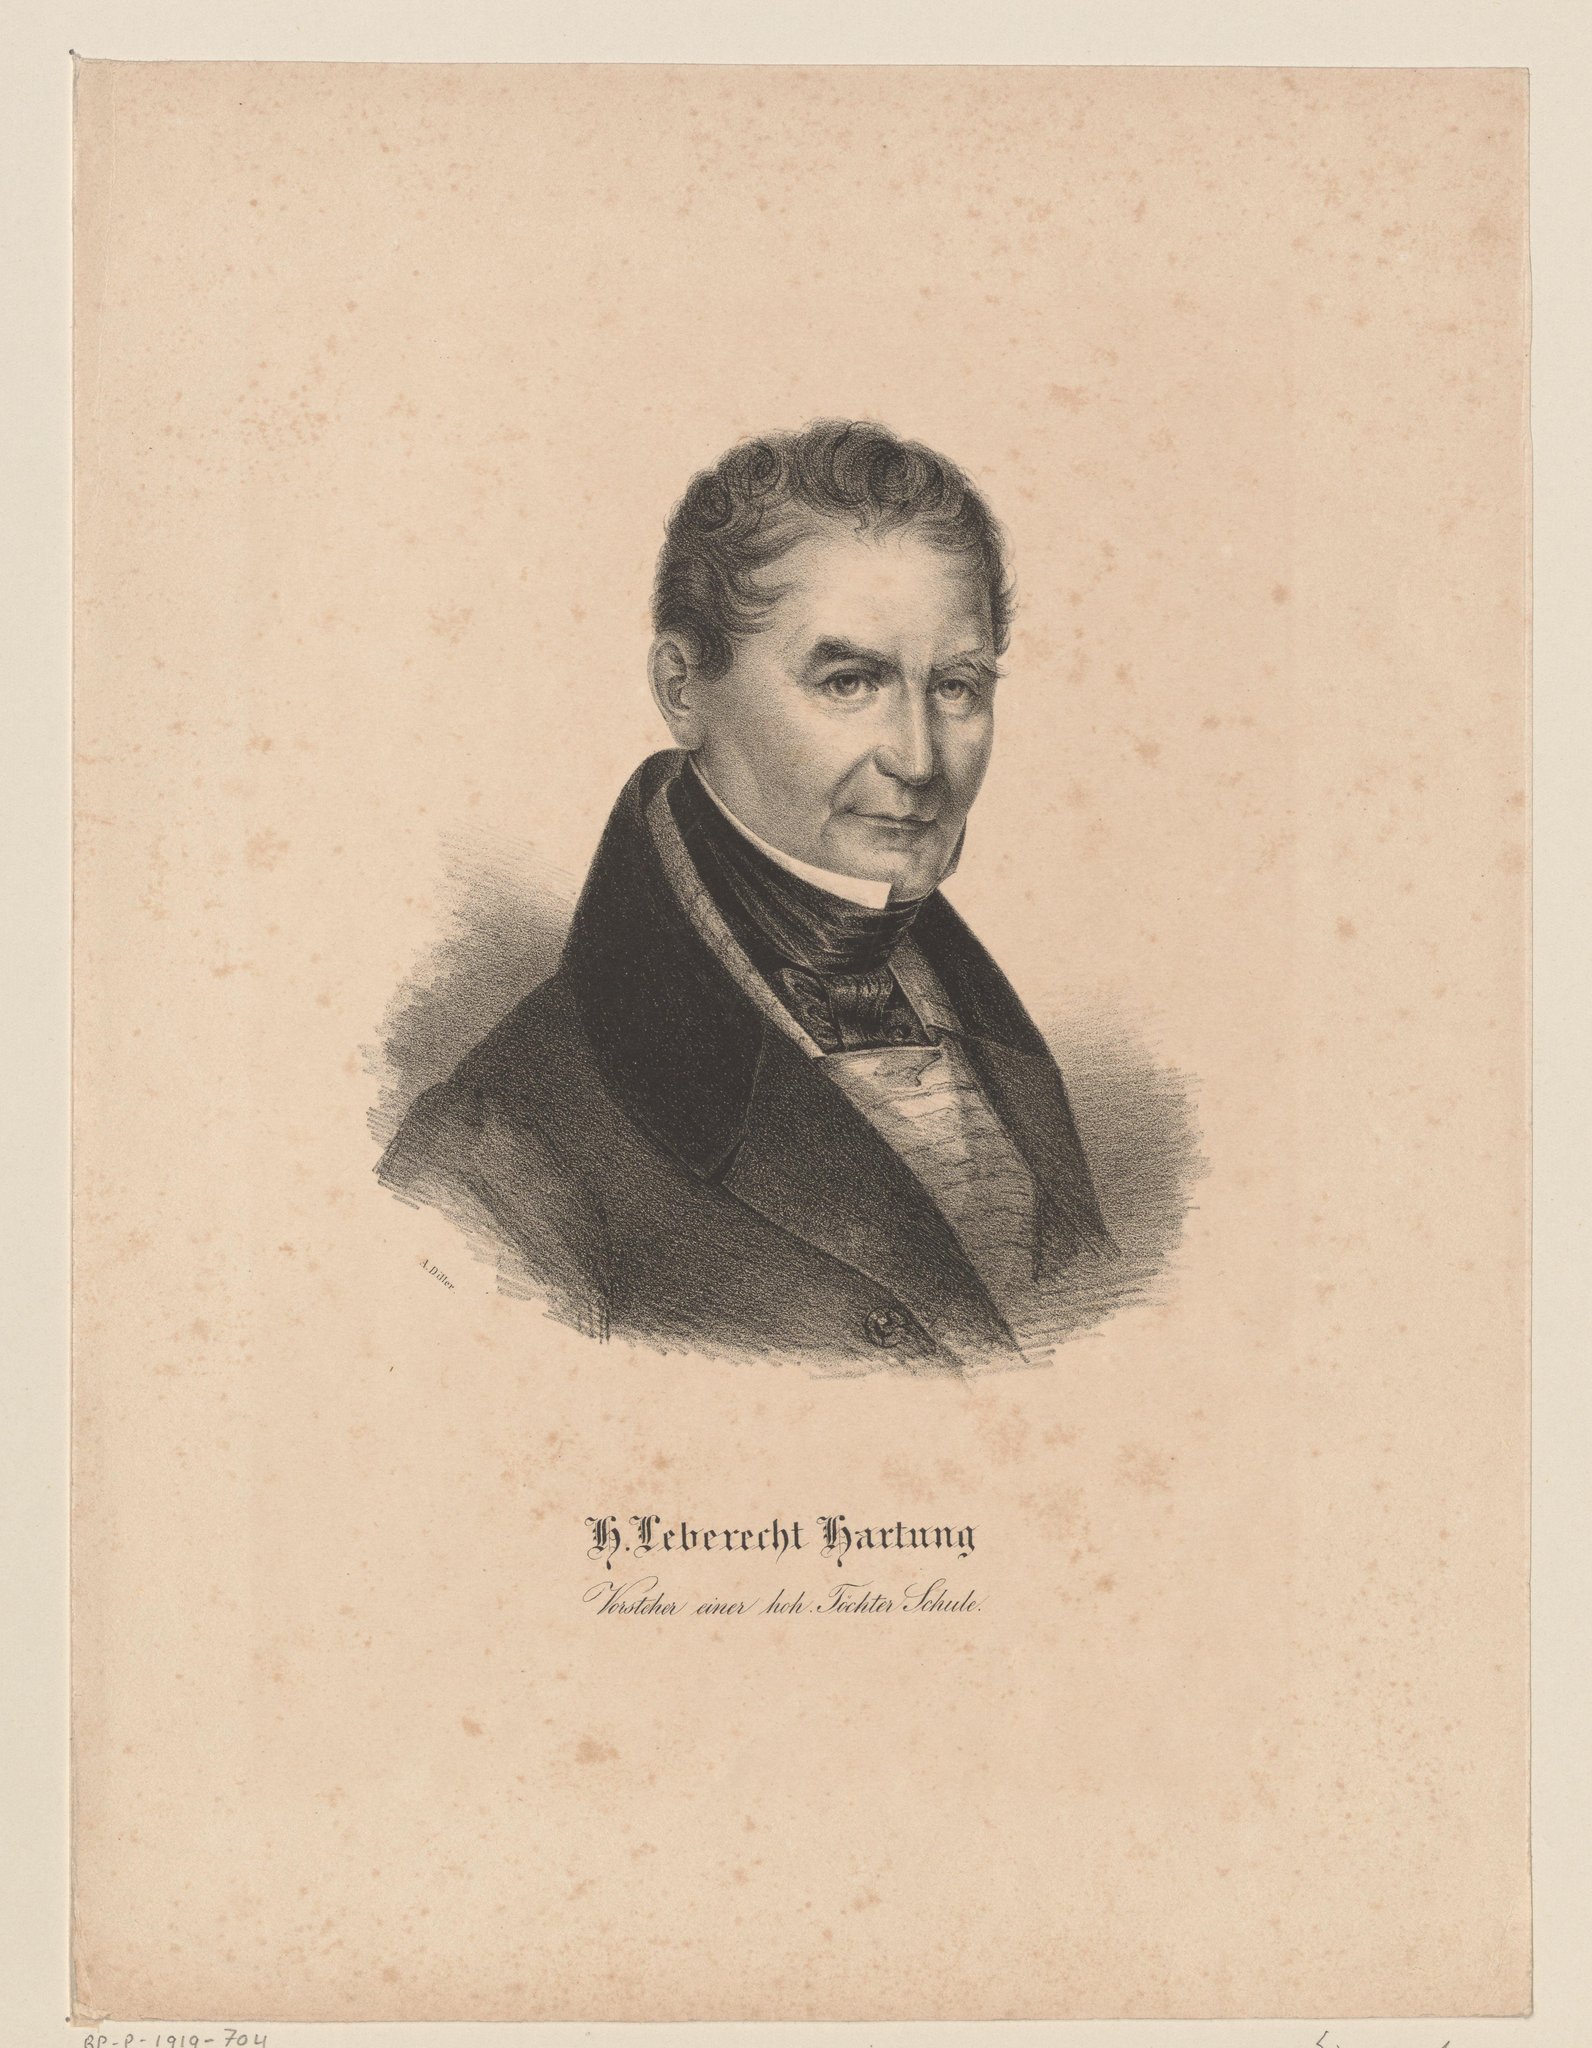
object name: print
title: Portret van Leberecht Hartung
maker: a. diller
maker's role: print maker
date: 1825-1874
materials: paper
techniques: lithograph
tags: historical persons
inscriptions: collector's mark: Lugt 2228